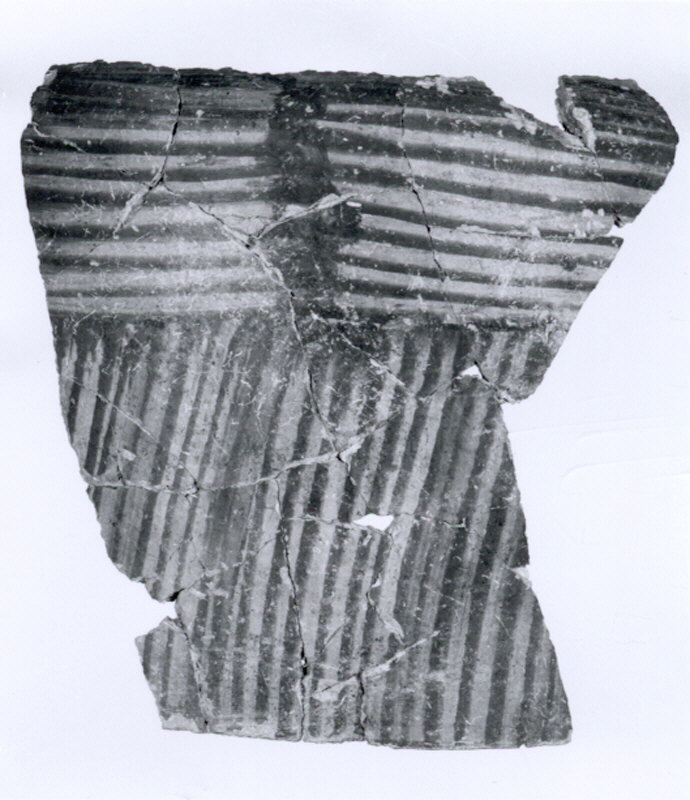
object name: bowl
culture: iranian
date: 5500 BCE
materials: ceramic, paint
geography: iran